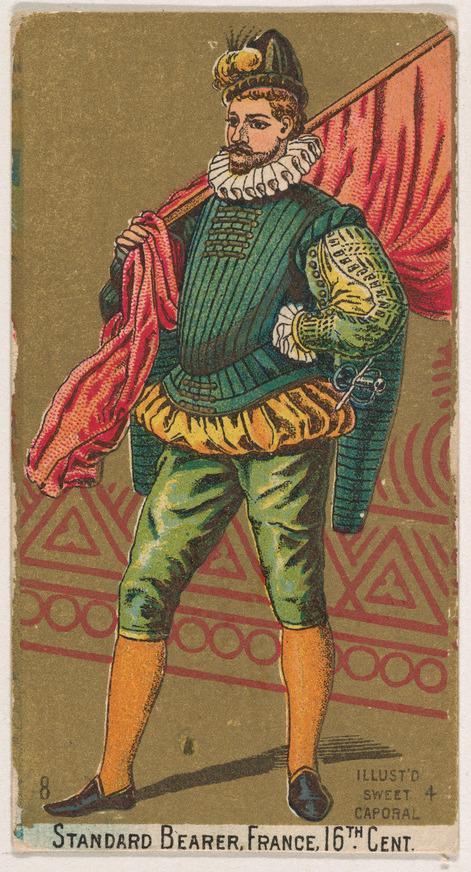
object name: print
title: Standard Bearer, France, 16th Century, from the Military Series (N224) issued by Kinney Tobacco Company to promote Sweet Caporal Cigarettes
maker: kinney brothers tobacco company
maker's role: publisher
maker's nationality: american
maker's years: 1869-2011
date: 1888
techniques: color lithograph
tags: military,men,flags